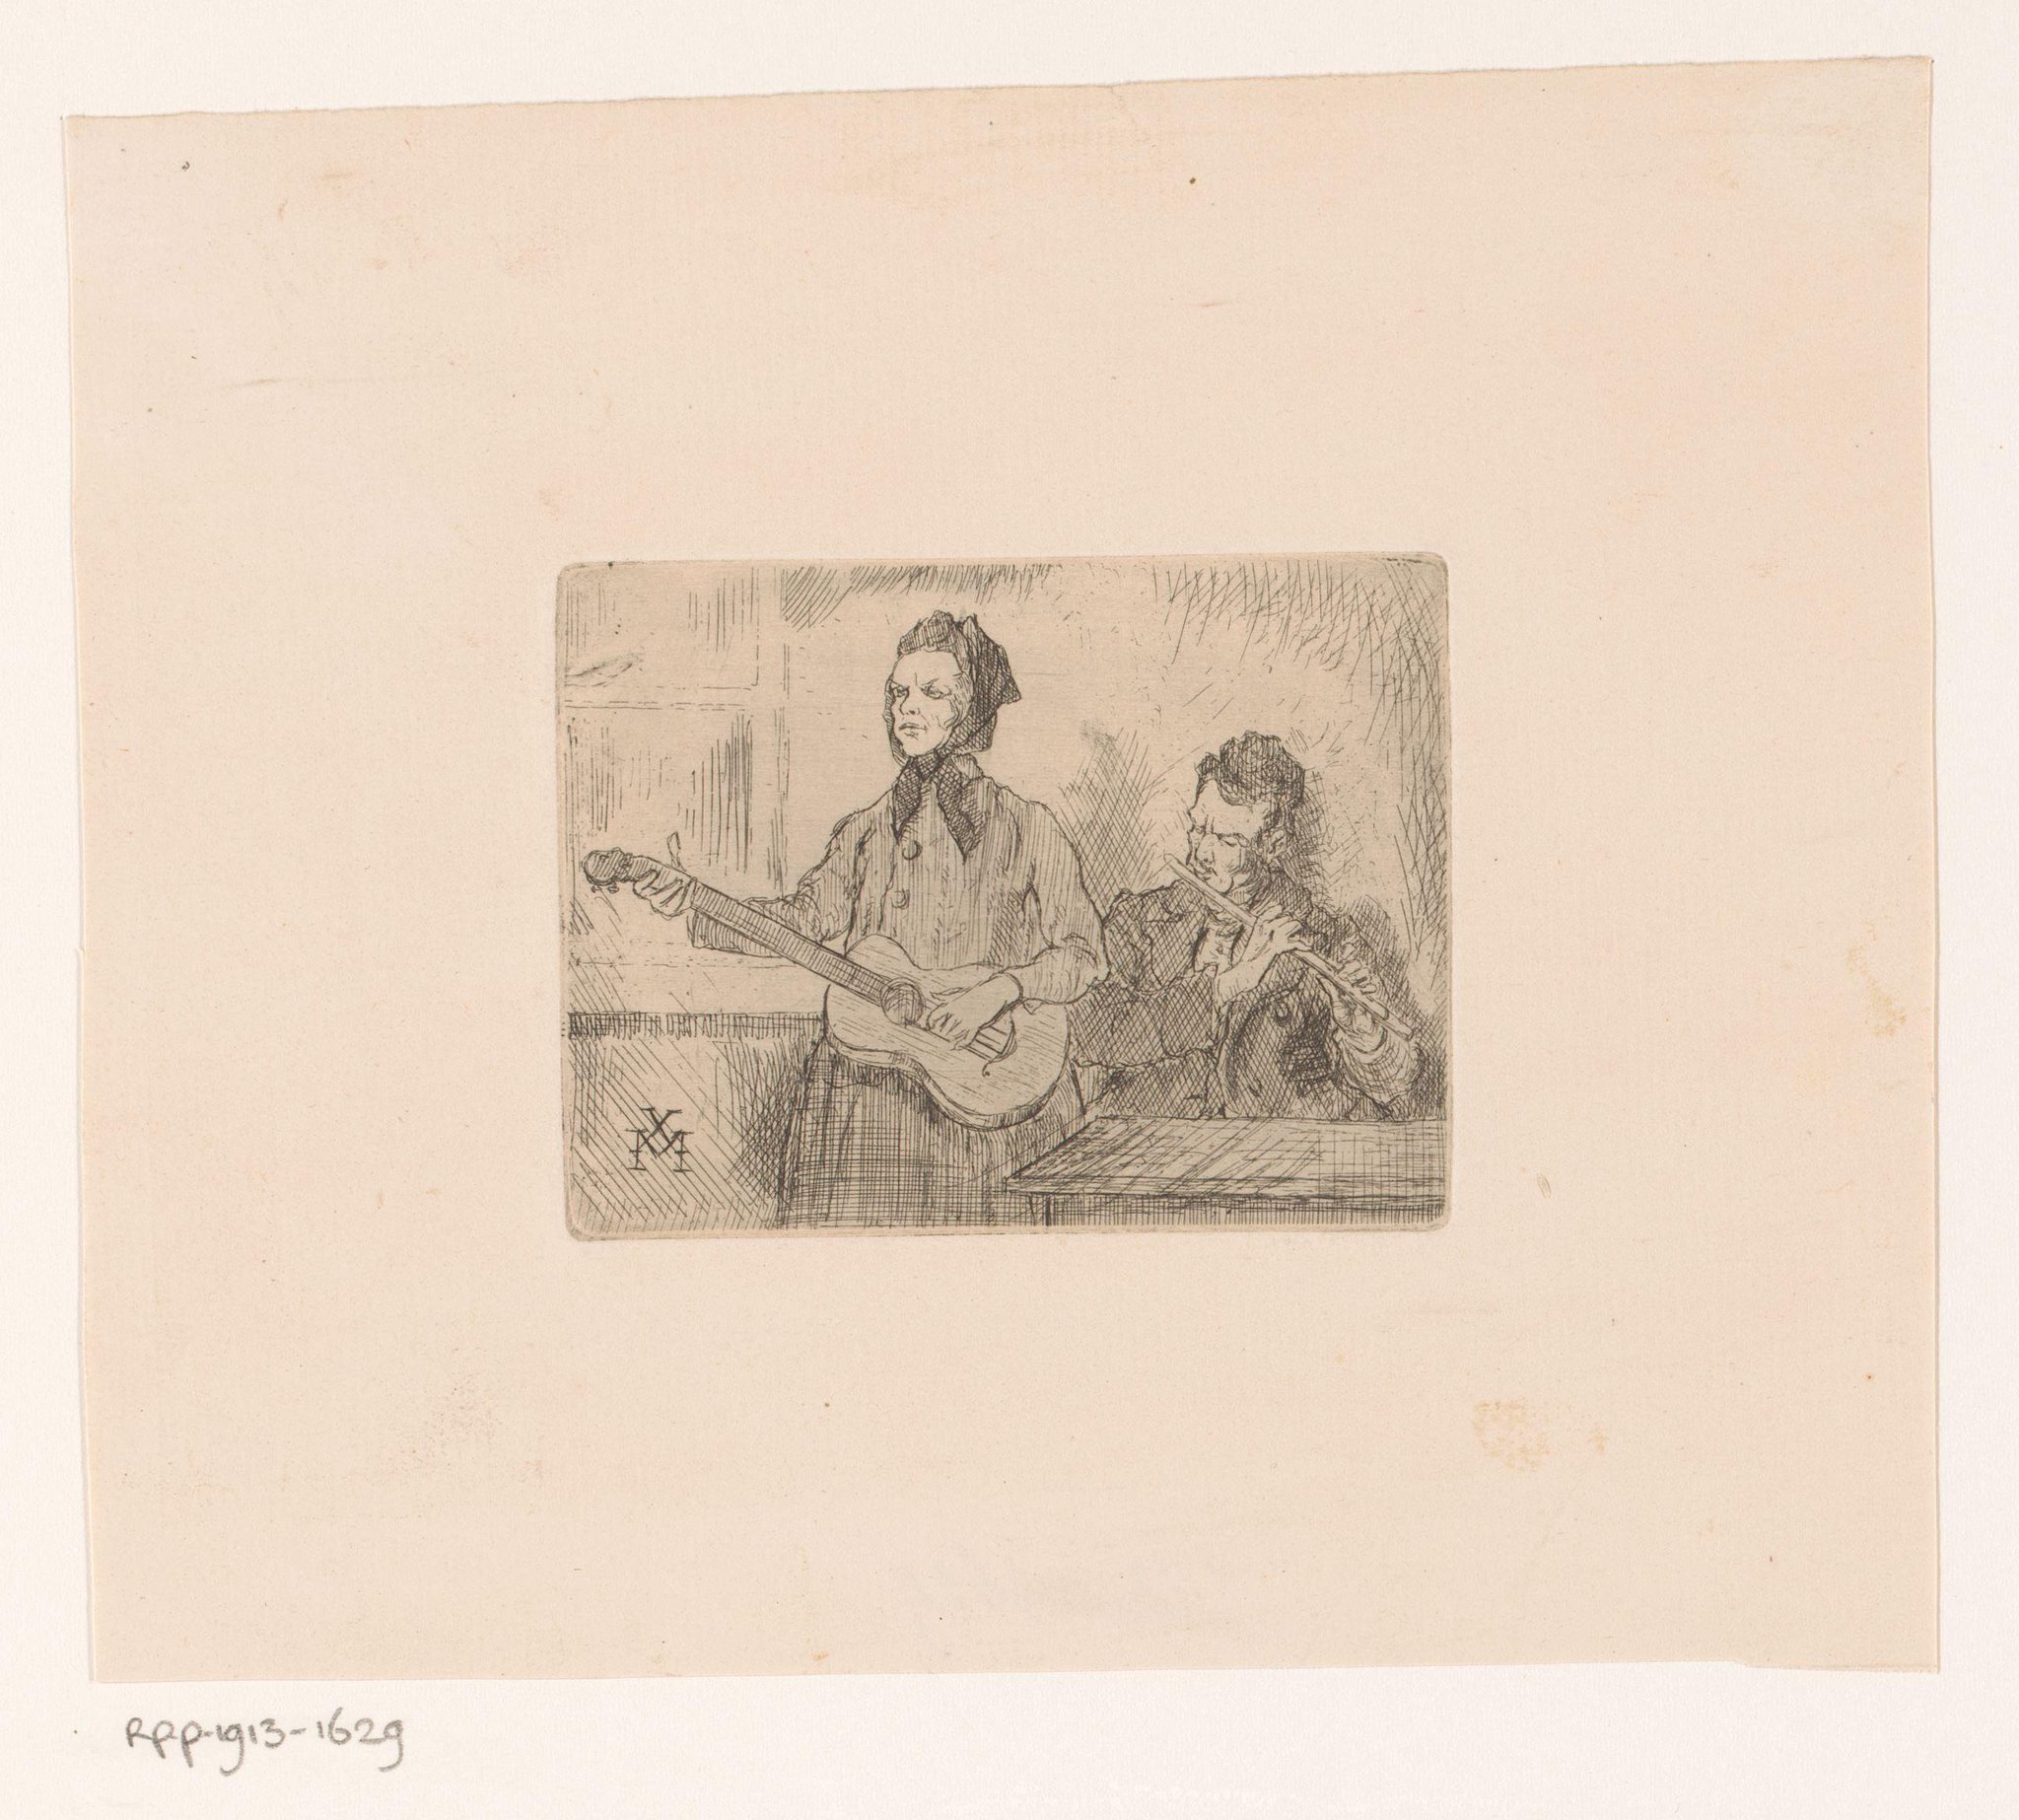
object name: print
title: Twee muzikanten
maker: xavier mellery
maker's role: print maker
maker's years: 1845-1921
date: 1855-1913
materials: paper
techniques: etching, intaglio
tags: transverse flute, cithern, mandolin, guitar, balalaika, more than one musician with instrument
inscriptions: collector's mark: Lugt 2228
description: Vrouw speelt op een gitaar en een man speelt dwarsfluit.